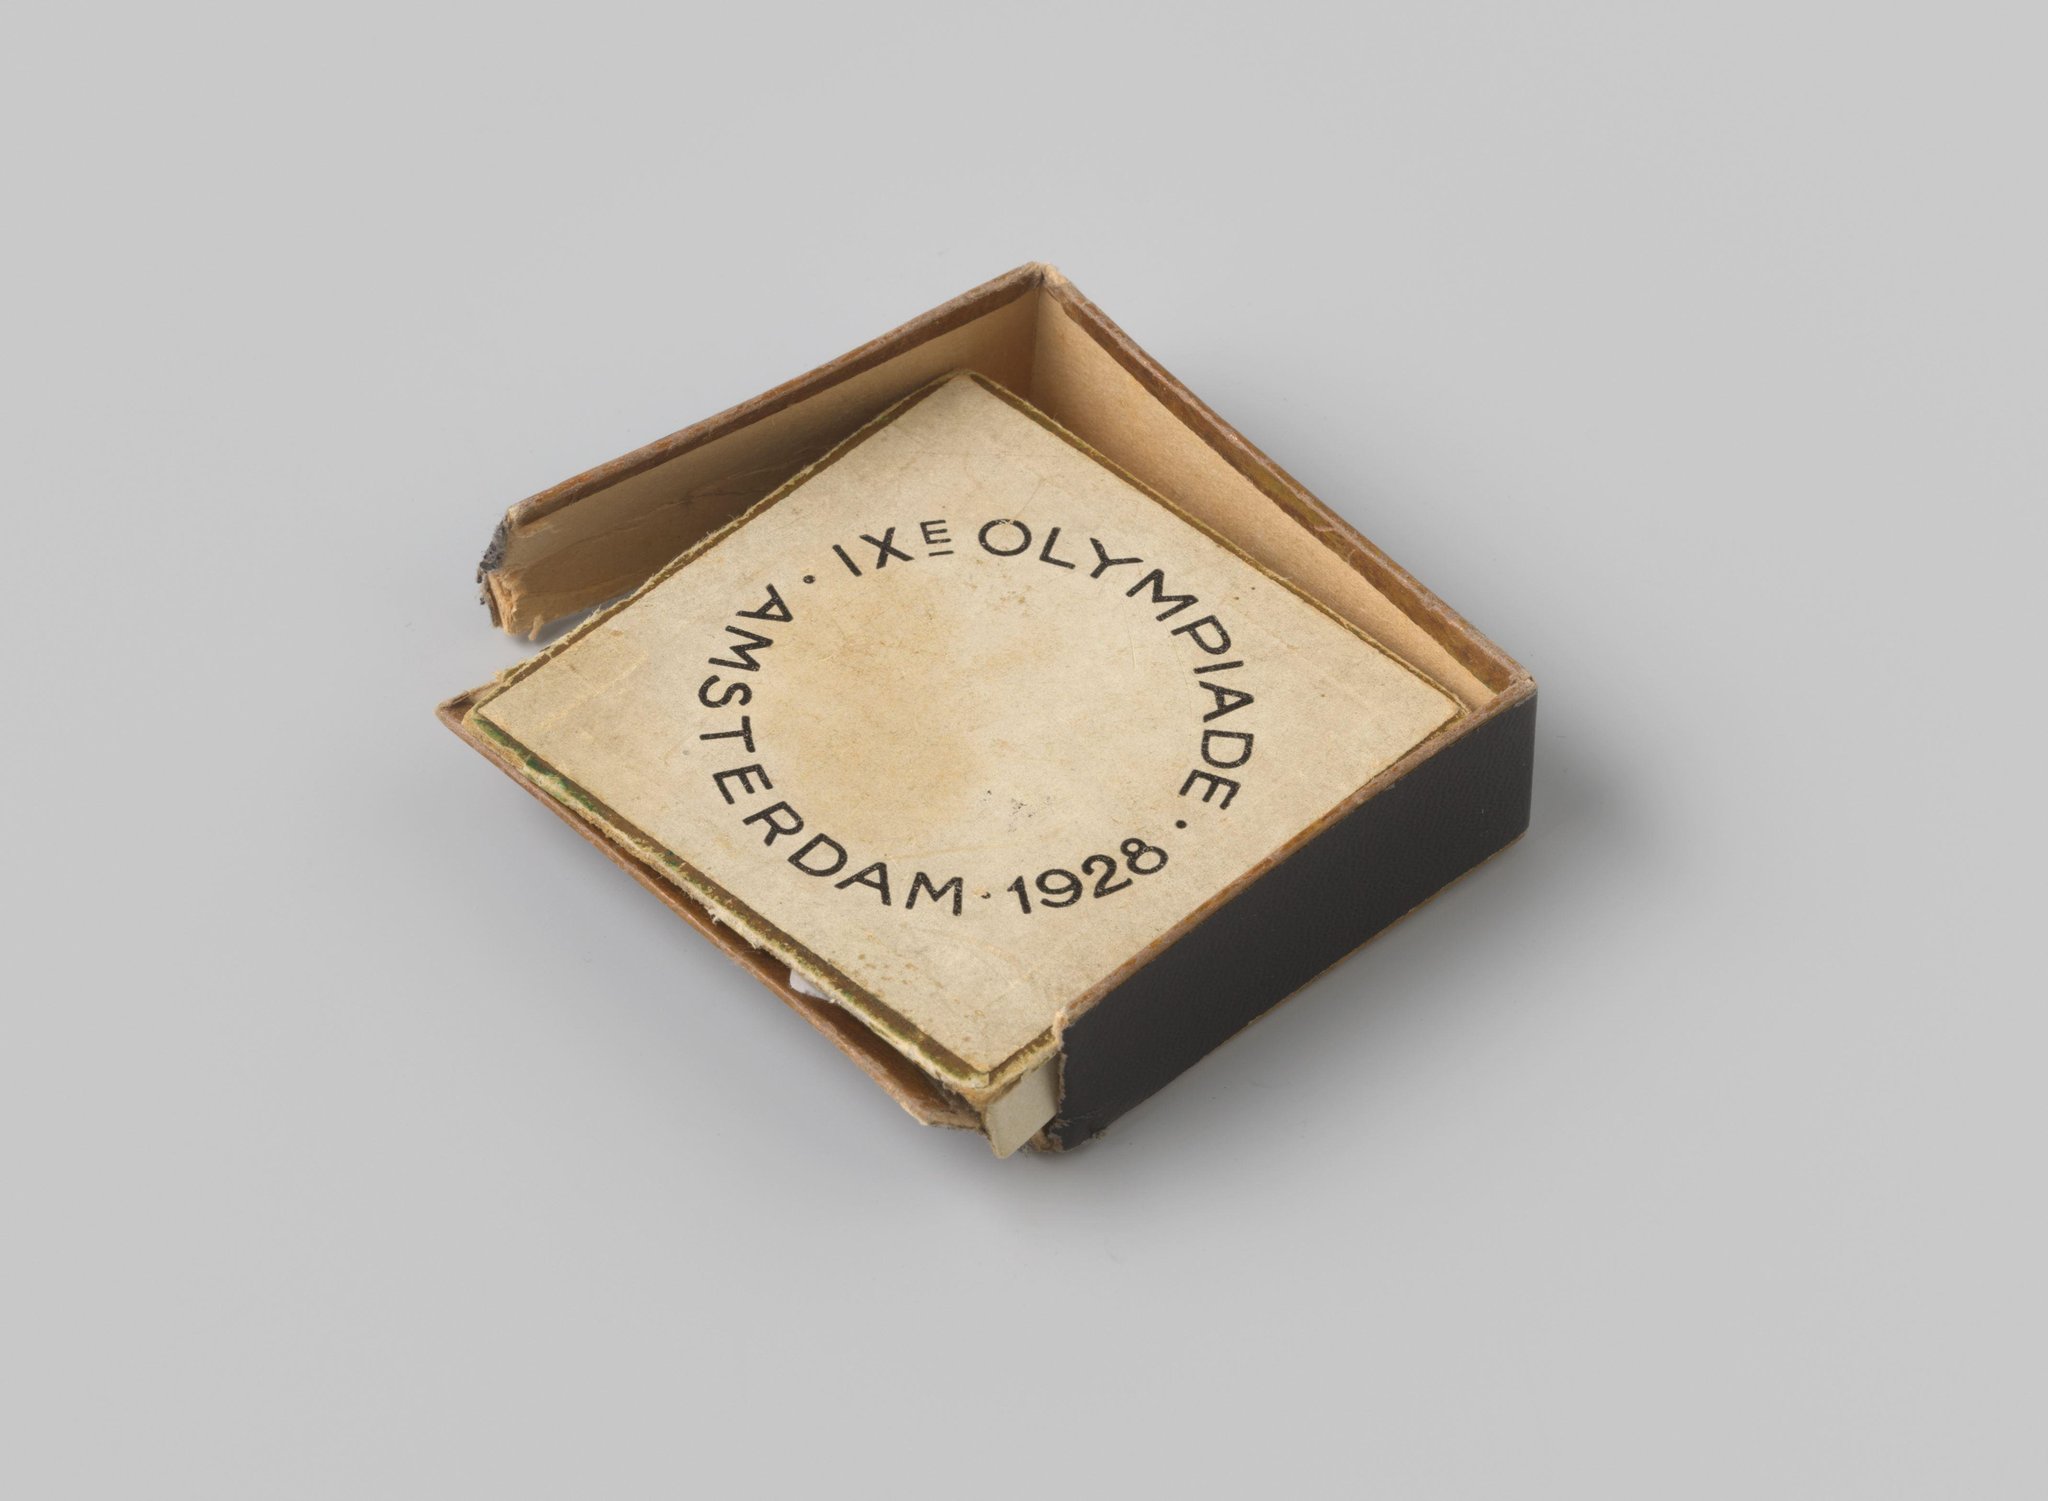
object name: medal box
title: Doosje bij penning van de Negende Olympiade (Olympische Spelen) te Amsterdam, 1928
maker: johannes cornelis wienecke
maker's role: medailleur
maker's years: 1872-1945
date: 1928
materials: cardboard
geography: netherlands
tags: amsterdam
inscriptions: inscription: ‘IXe OLYMPIADE AMSTERDAM 1928’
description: Vierkant kartonnen doosje met los deksel. Zijkanten donkerblauw of zwart; boven- en onderkant wit. Gouden randjes. Deksel bedrukt met zwarte letters. Binnenzijde deksel beplakt met blauw fluweel.